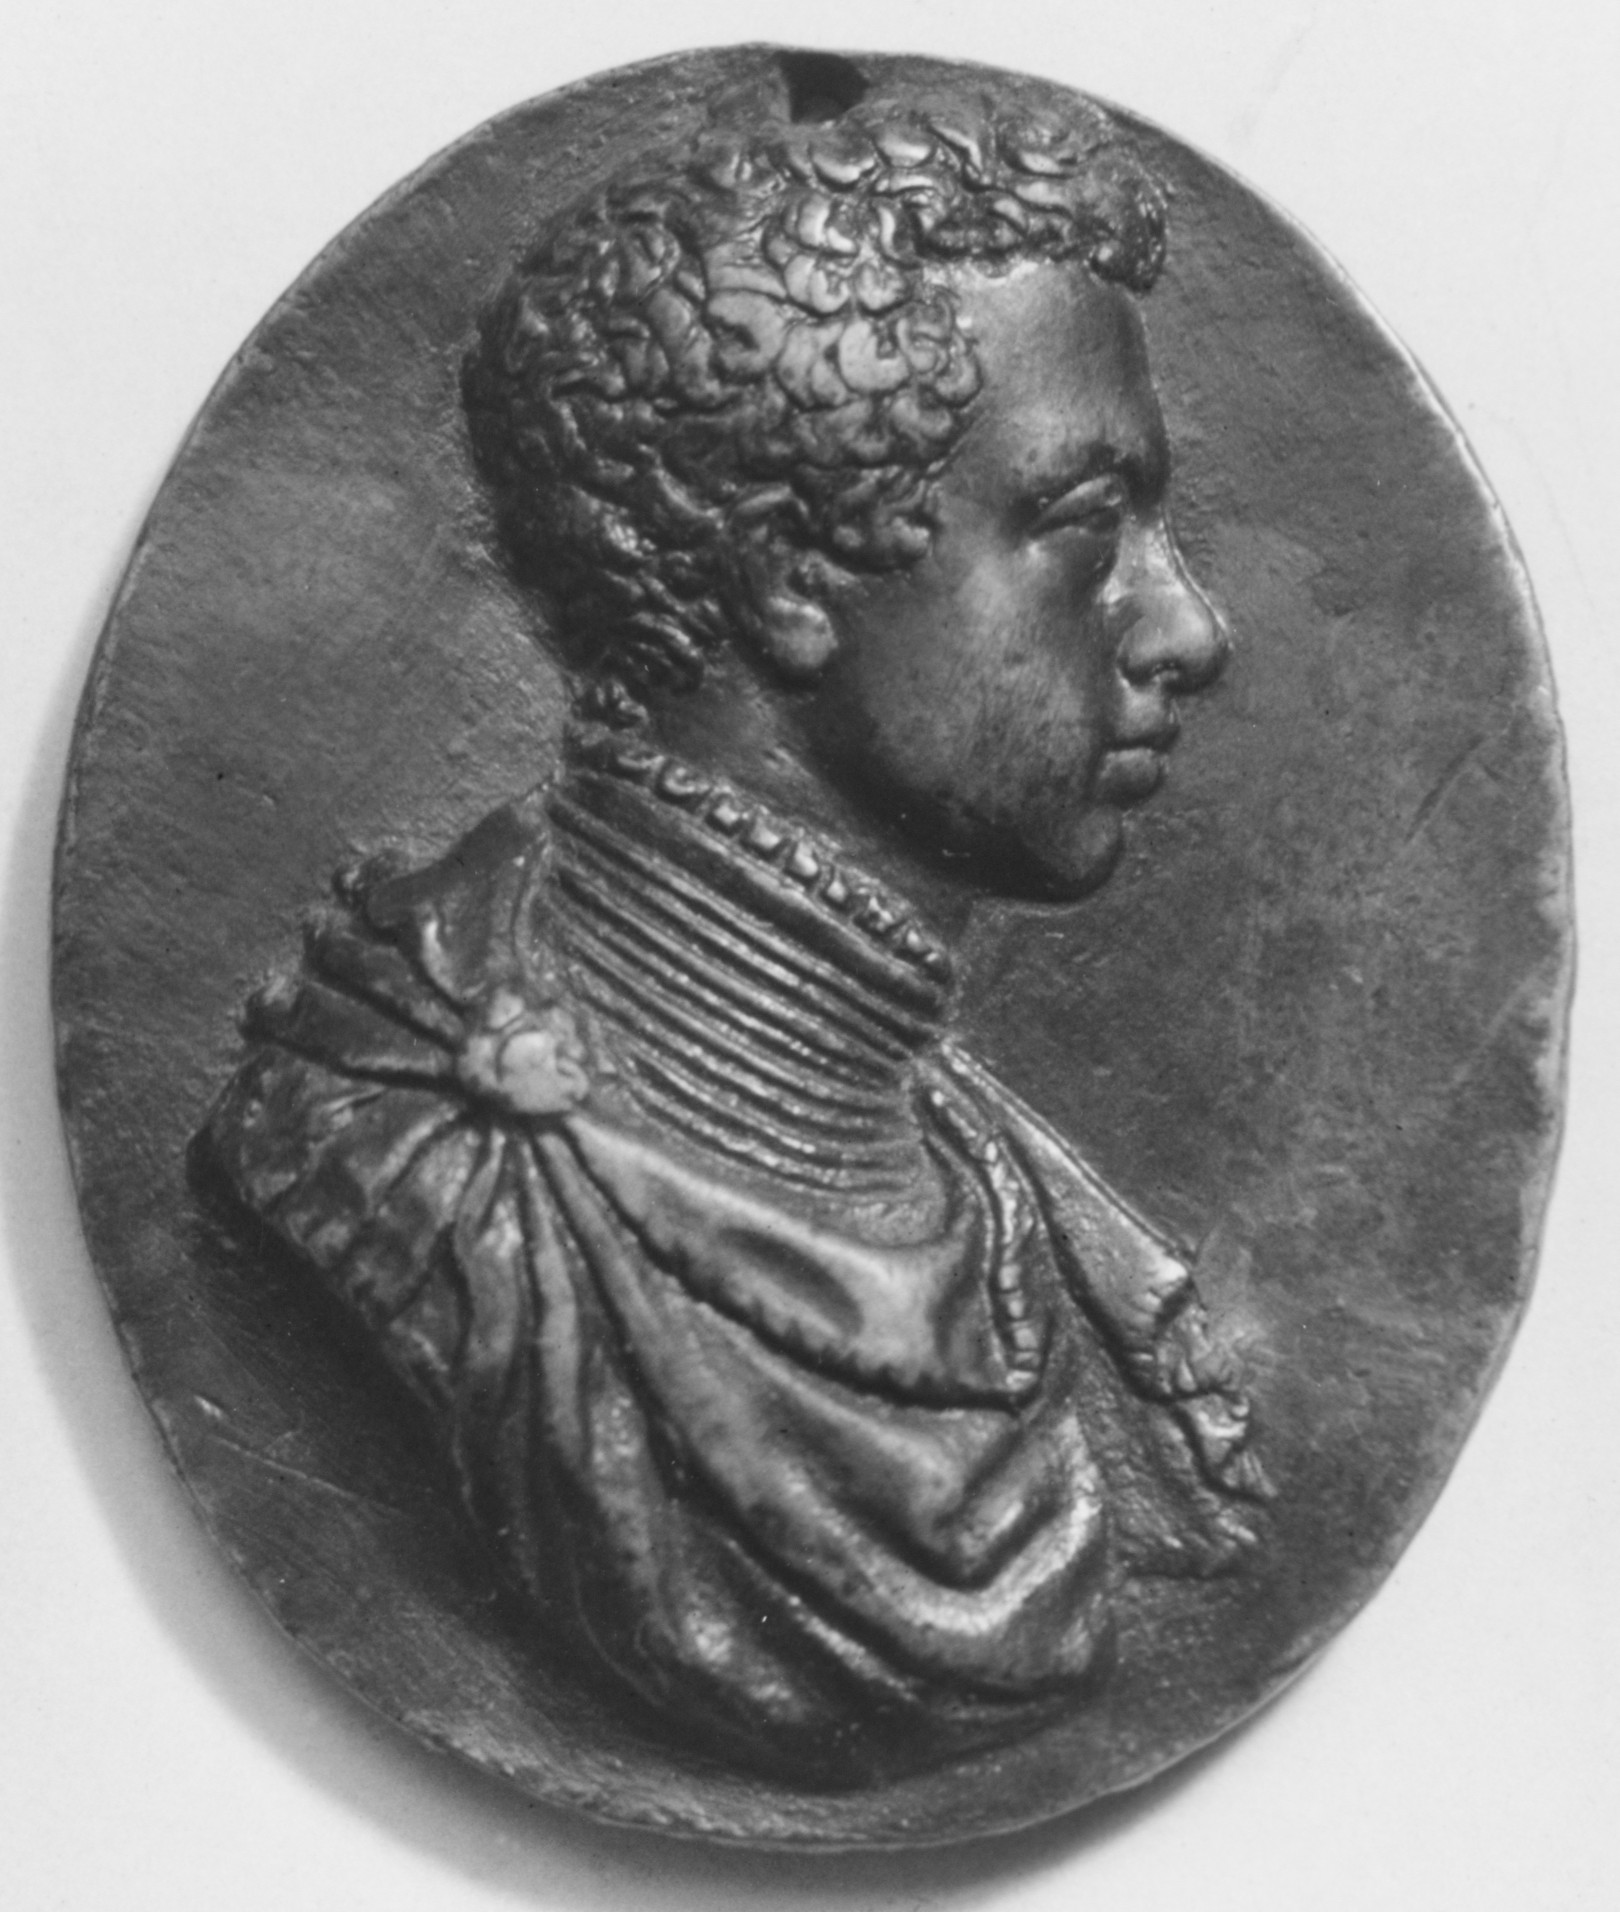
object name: medal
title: Probably Alessandro Farnese, 3rd Duke of Parma and Piacenza, about 14 years old (1545–1592)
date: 1560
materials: bronze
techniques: casting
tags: men,profiles